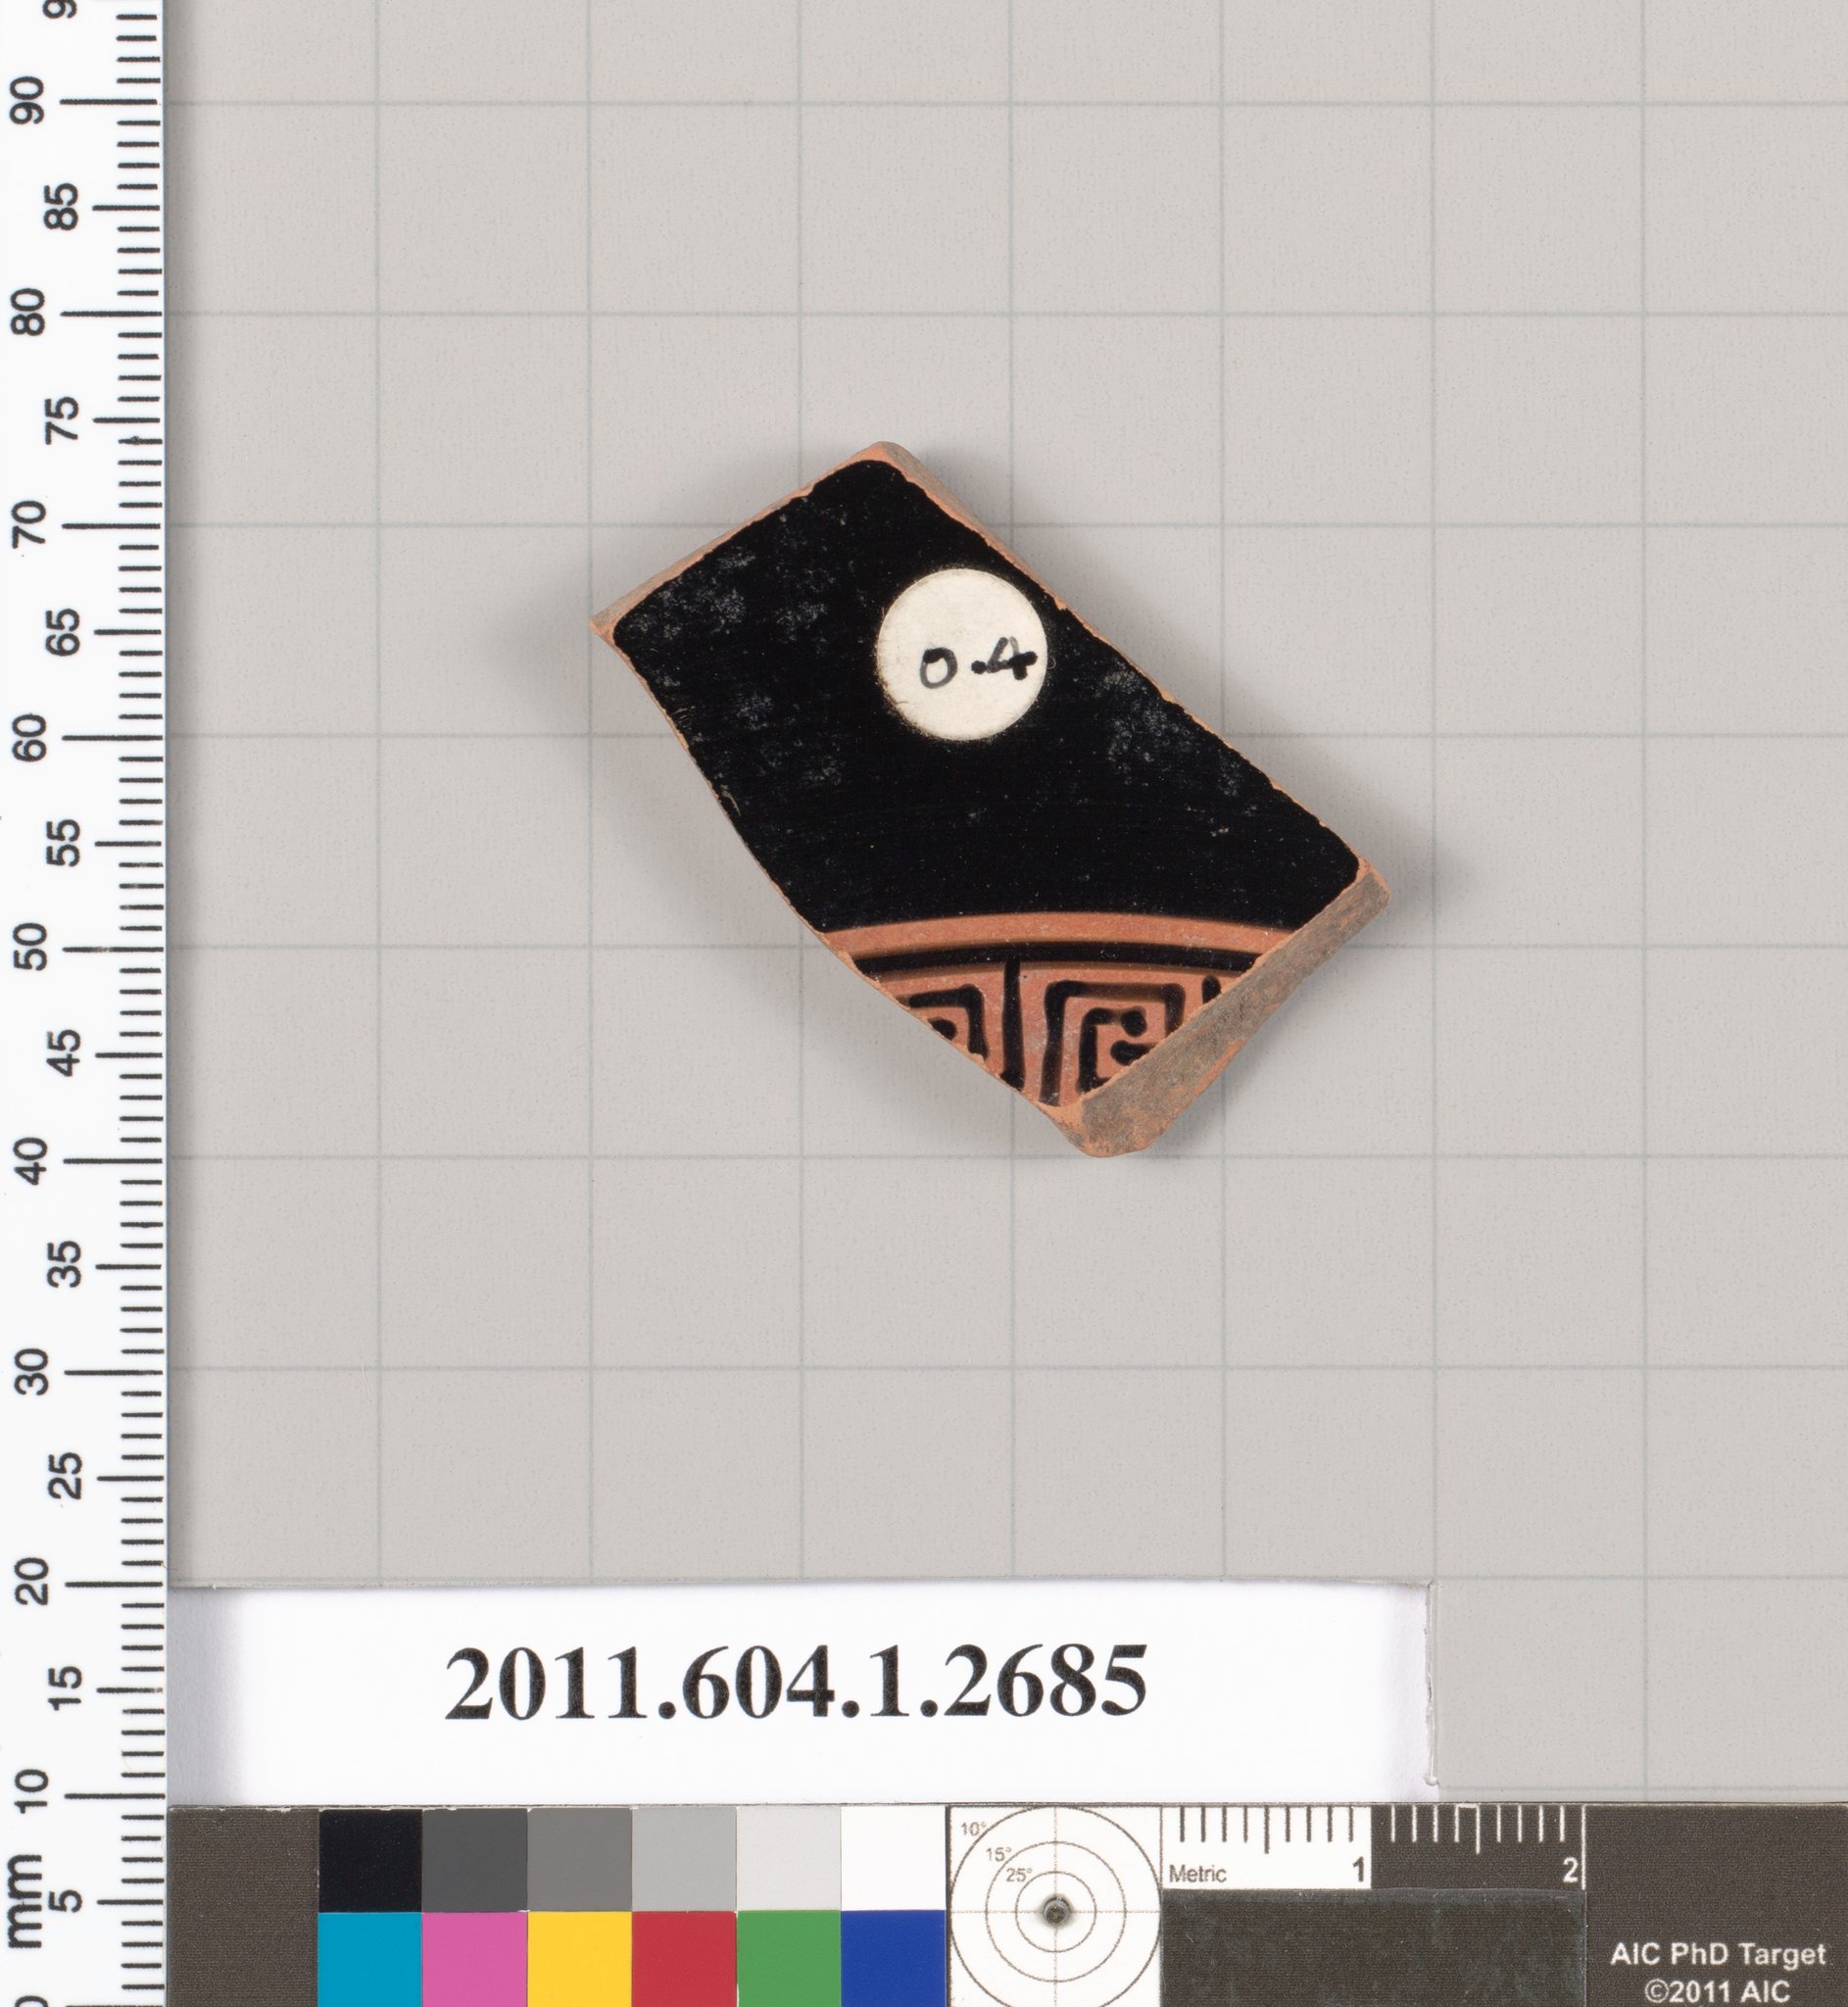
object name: kylix fragment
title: Terracotta fragment of a kylix (drinking cup)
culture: greek, attic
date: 500-480 BCE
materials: terracotta